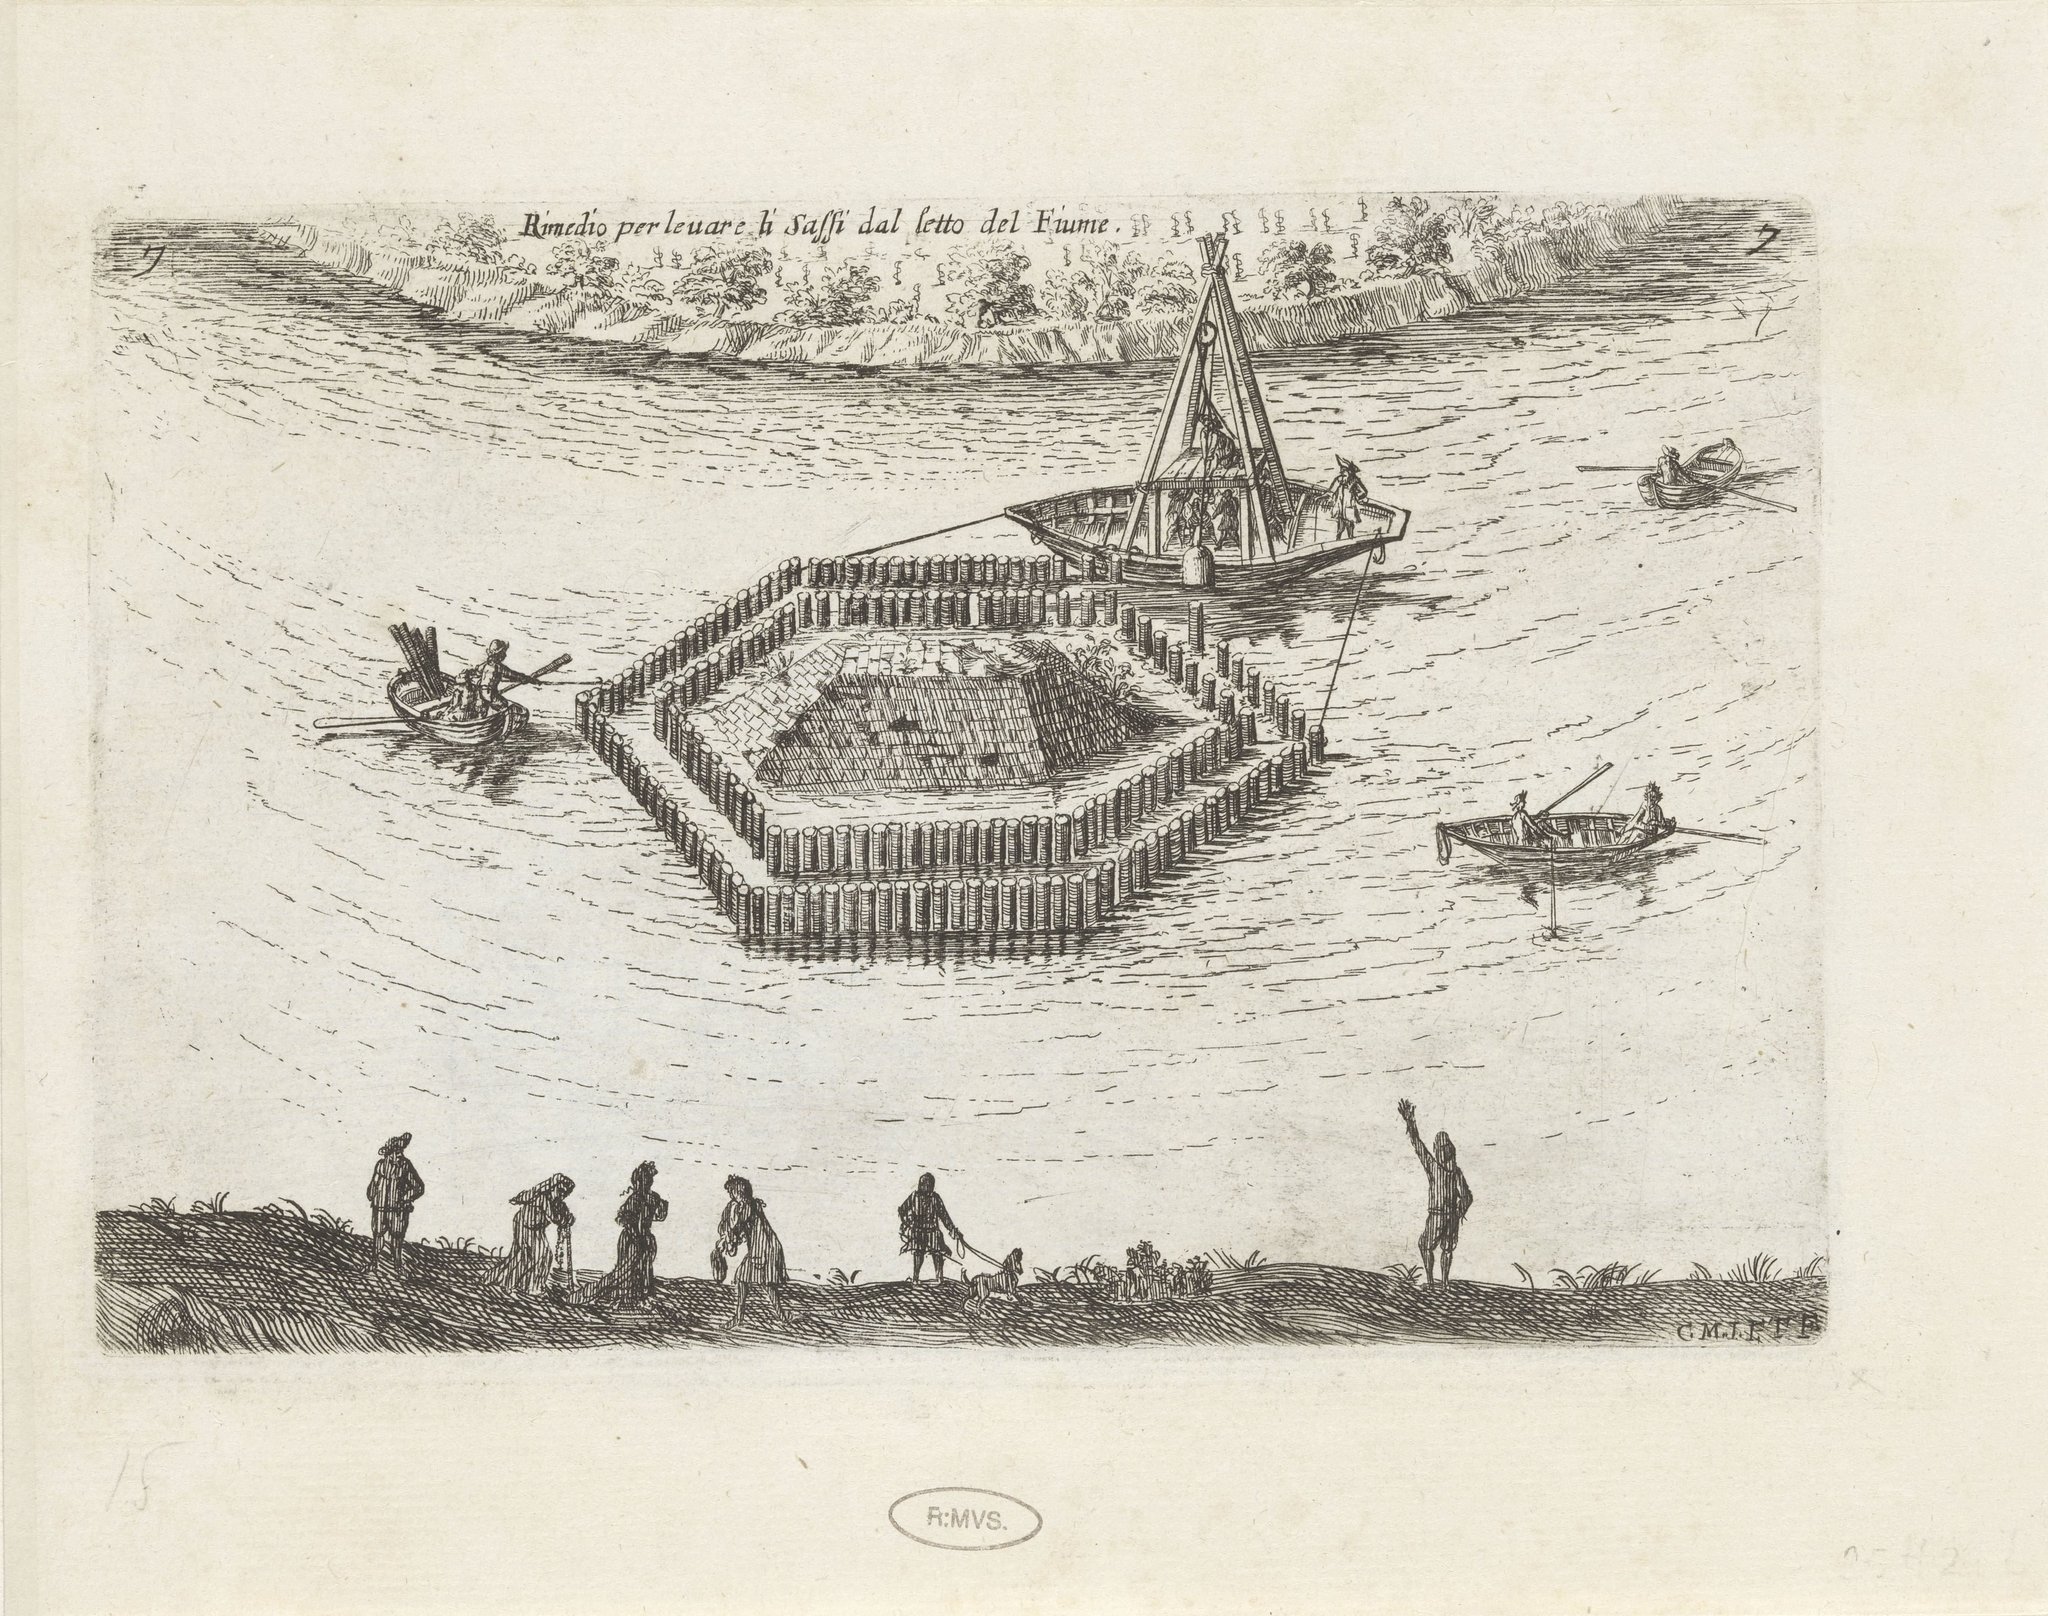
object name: print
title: L'arte di rendere i fiumi navigabili, in varij modi, con altre nuove inventioni, e varij altri segreti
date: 1677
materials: paper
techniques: etching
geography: rome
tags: river, ships (in general), working class, labourers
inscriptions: collector's mark: Lugt 2228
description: Deze prent maakte oorspronkelijk deel uit van een publicatie bestaande uit drie delen, uitgegeven door G.G. Komarek in Rome in 1696. Het eerste deel zit achter een titelpagina met de titel: L'arte di rendere i fiumi navigabili, in varij modi, con altre nuove inventioni, e varij altri segreti. Deel twee zit achter een titelpagina met de titel: Racolta di varii segreti come si vedono nelle segventi figure. Deel drie zit achter een titelpagina met de titel: Osservazioni delle comete che dovranno seguire, e dell'ecclisse del primo satellite di Giove, et altre propositioni prosicue da farsi per commodo & ornamento della città. Deze prent komt uit het eerste deel. Prenten in de publicatie zijn naar ontwerp van Cornelis Meijer gemaakt door verschillende prentmakers, onder wie G.B. Falda, G. van Wittel, Gomar Wouters, etc. Er is ook een eerdere versie bekend van deze publicatie, uitgegeven in Rome in 1683, met de titel: L'arte di restituire a Roma la tralasciata navigazione del suo Tevere.